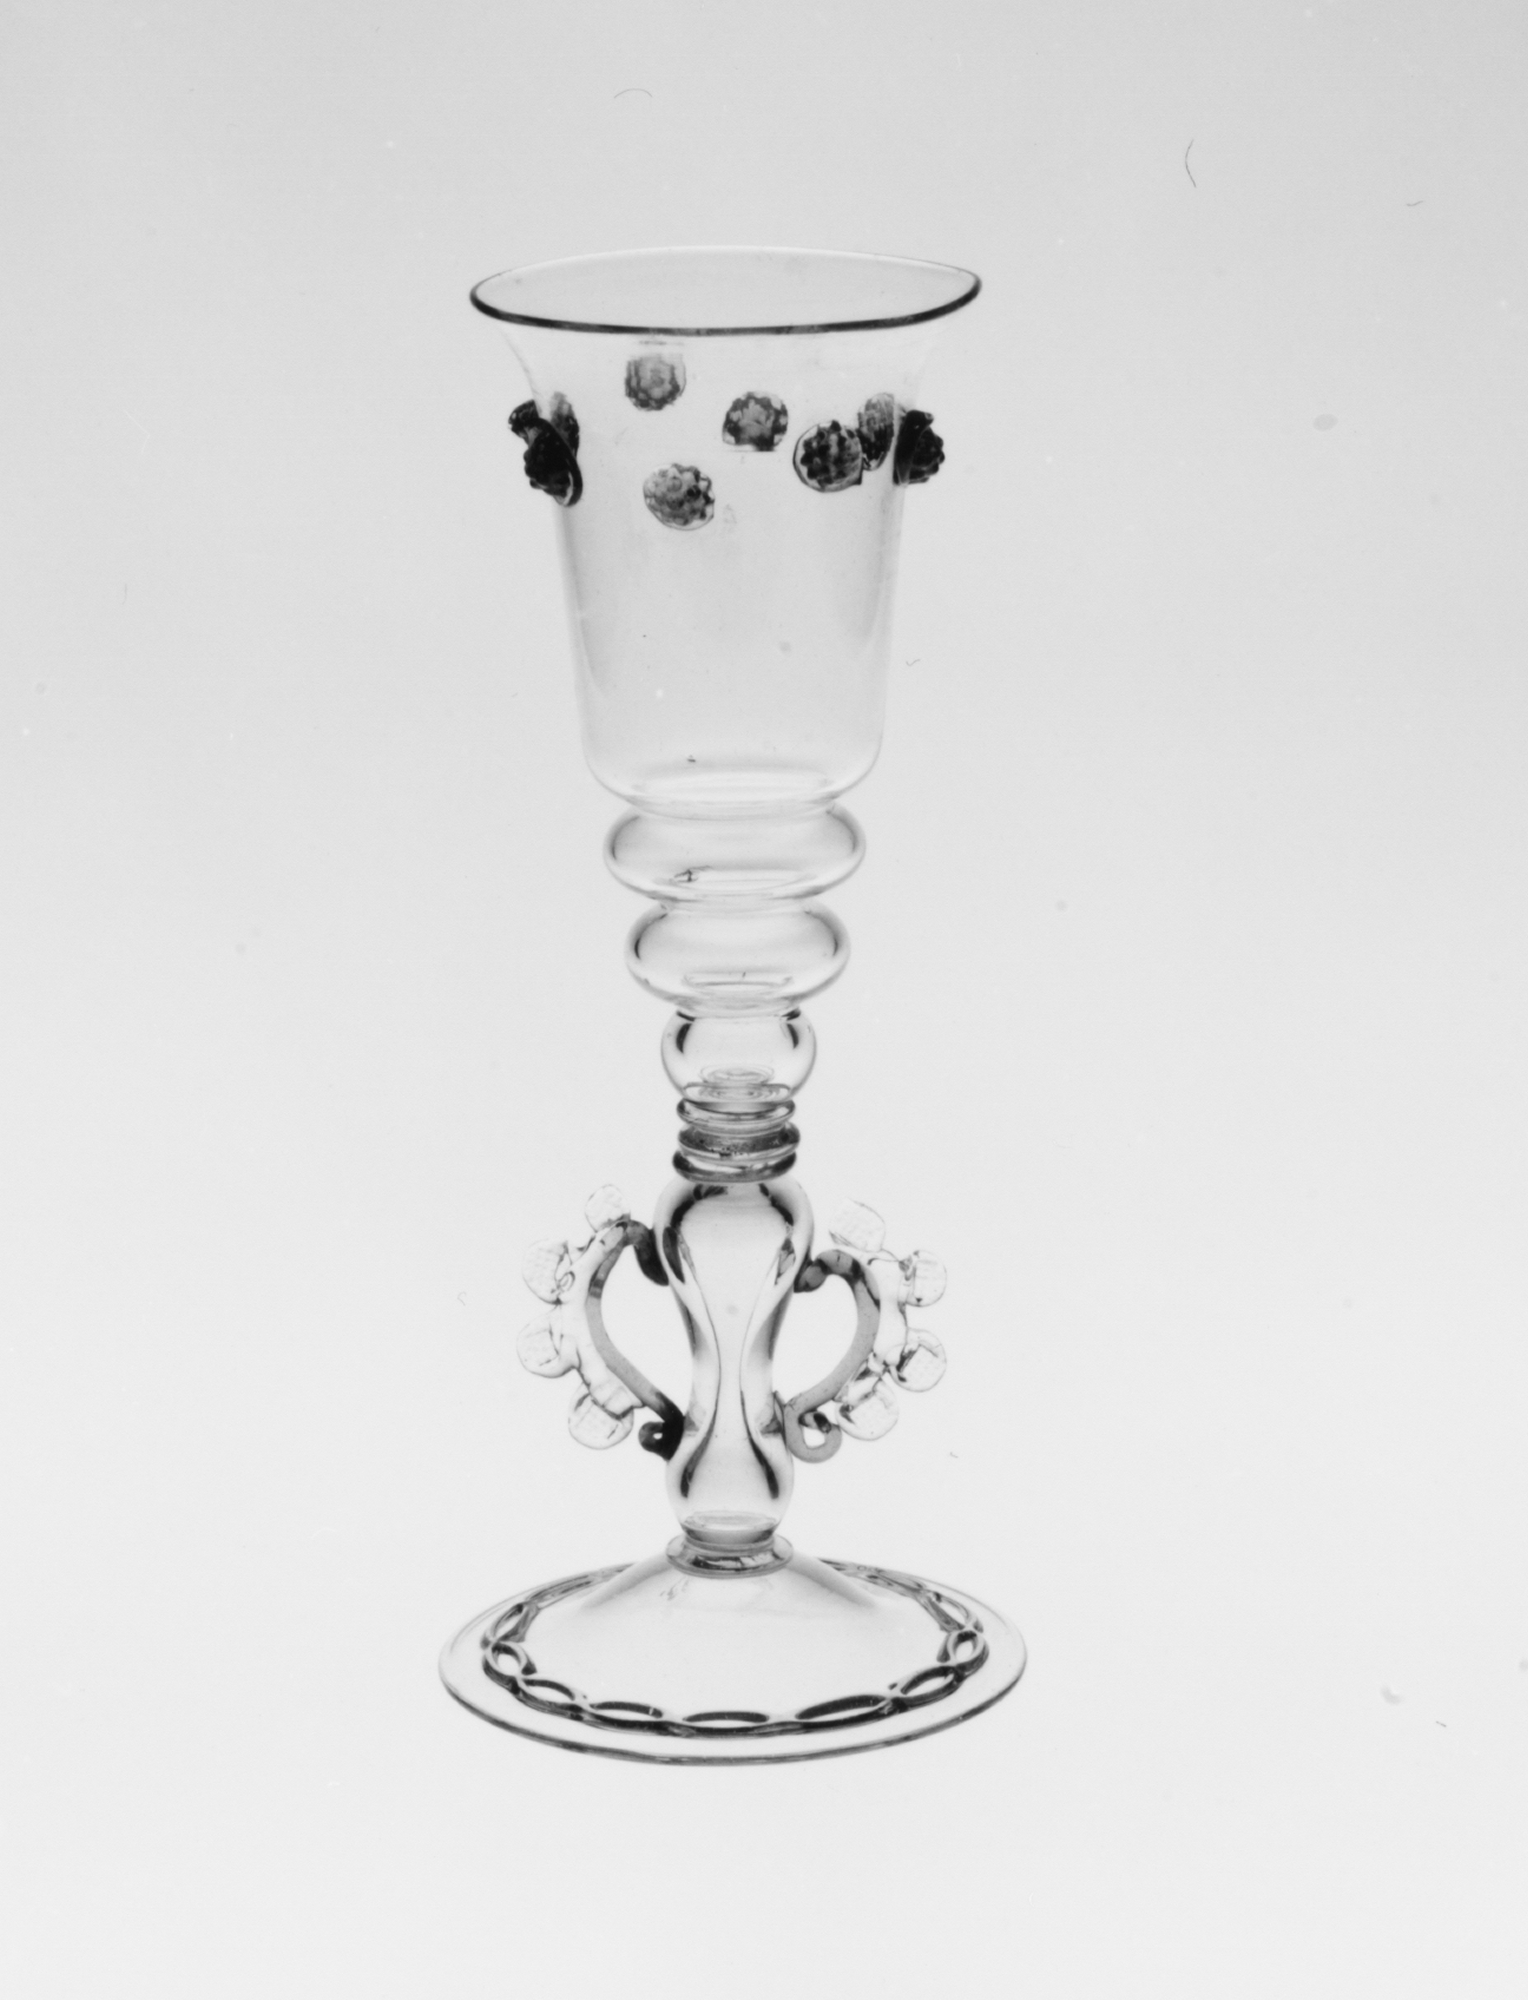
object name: goblet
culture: italian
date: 1867-1900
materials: glass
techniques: glassblowing